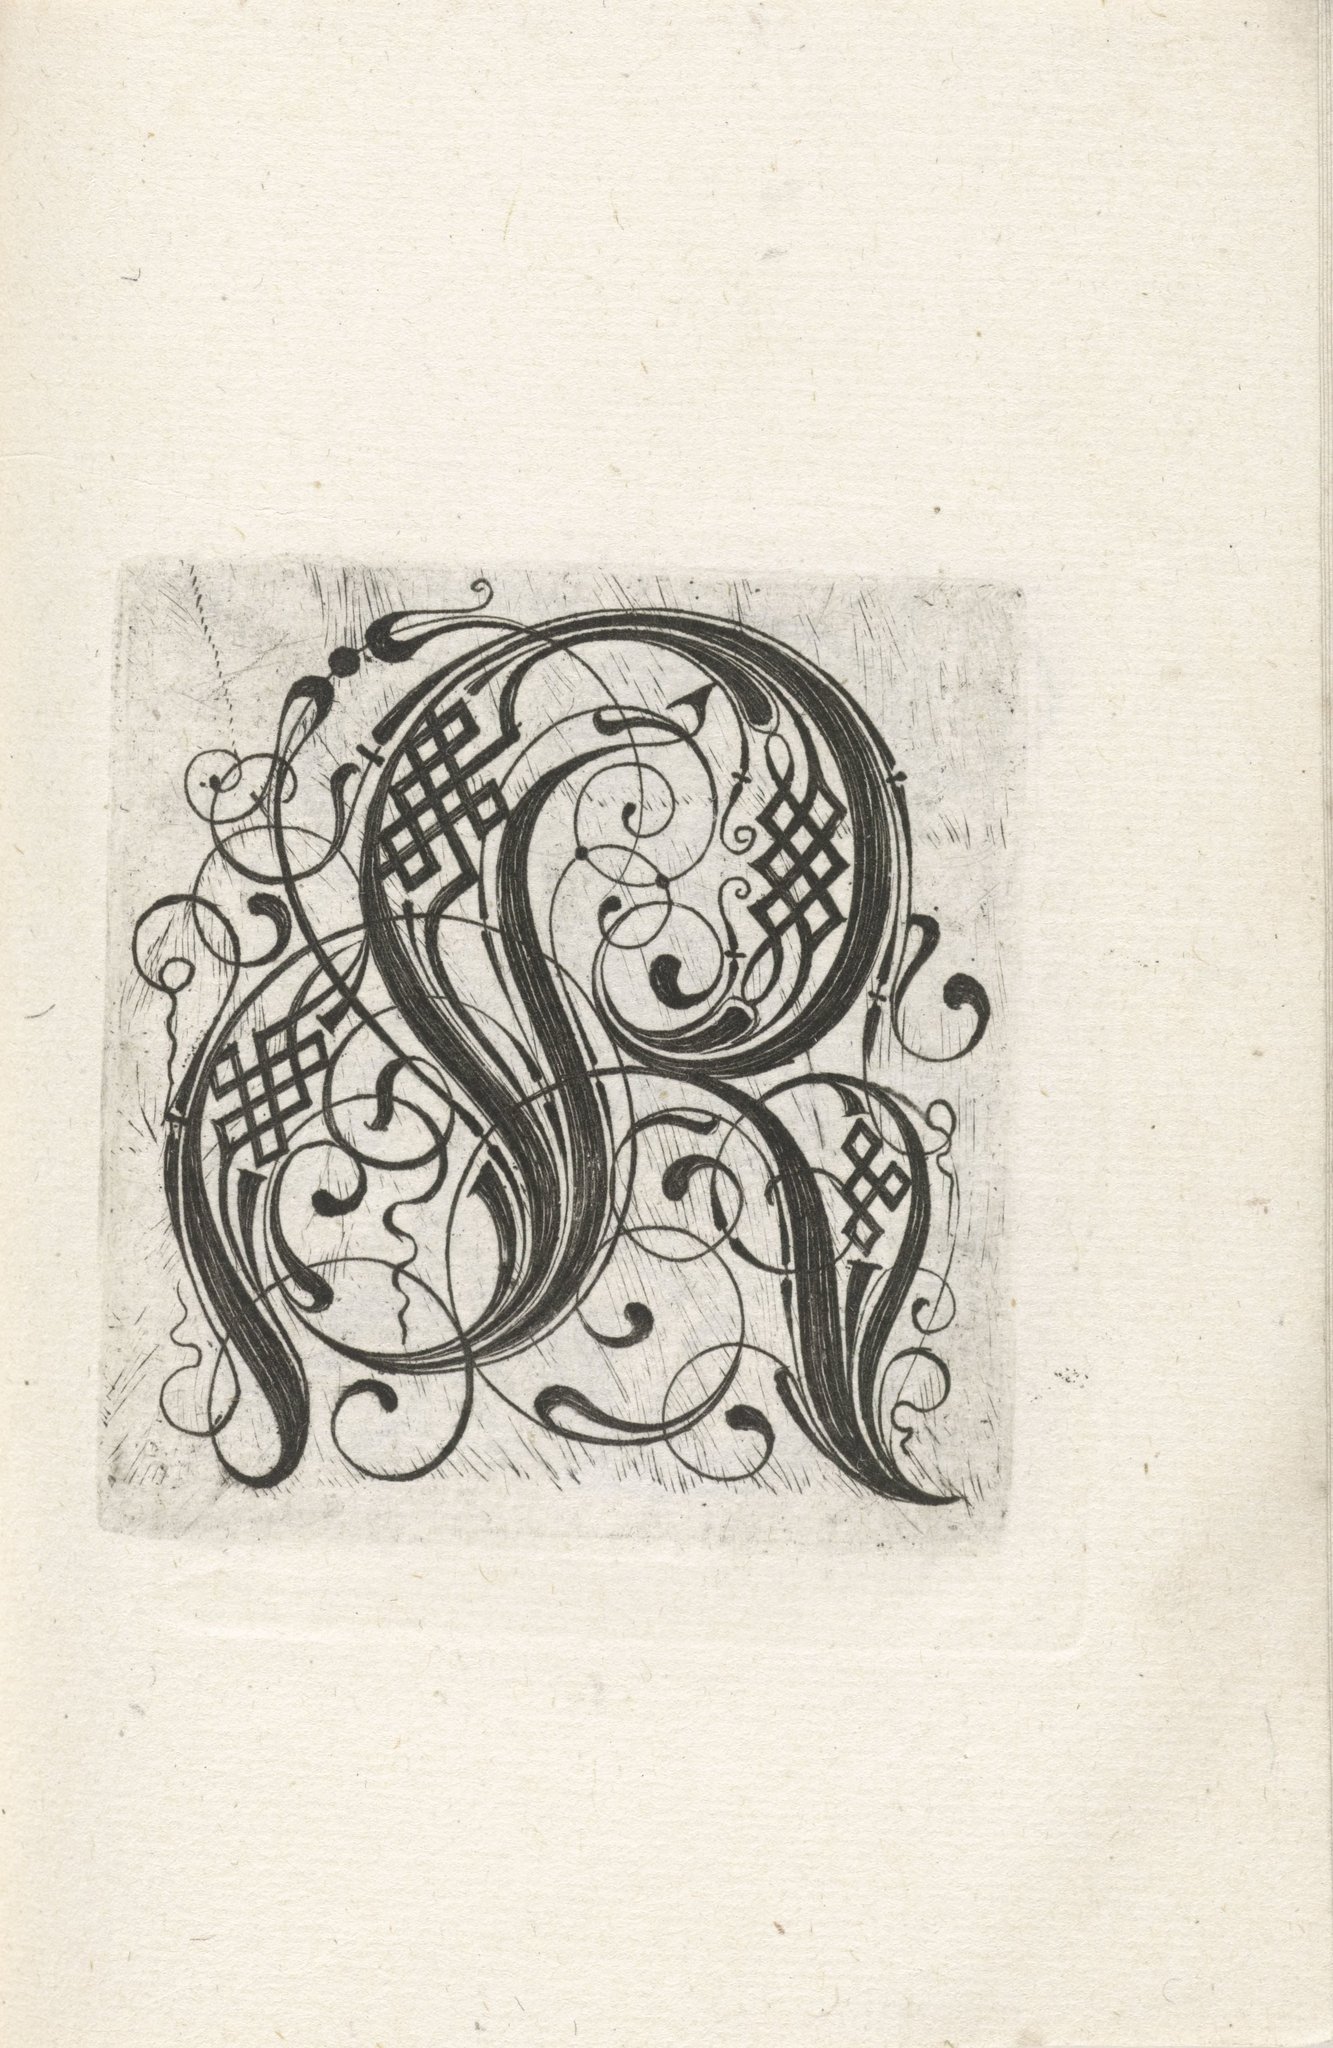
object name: print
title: Letter R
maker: Anonymous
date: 1600-1699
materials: paper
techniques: engraving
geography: netherlands